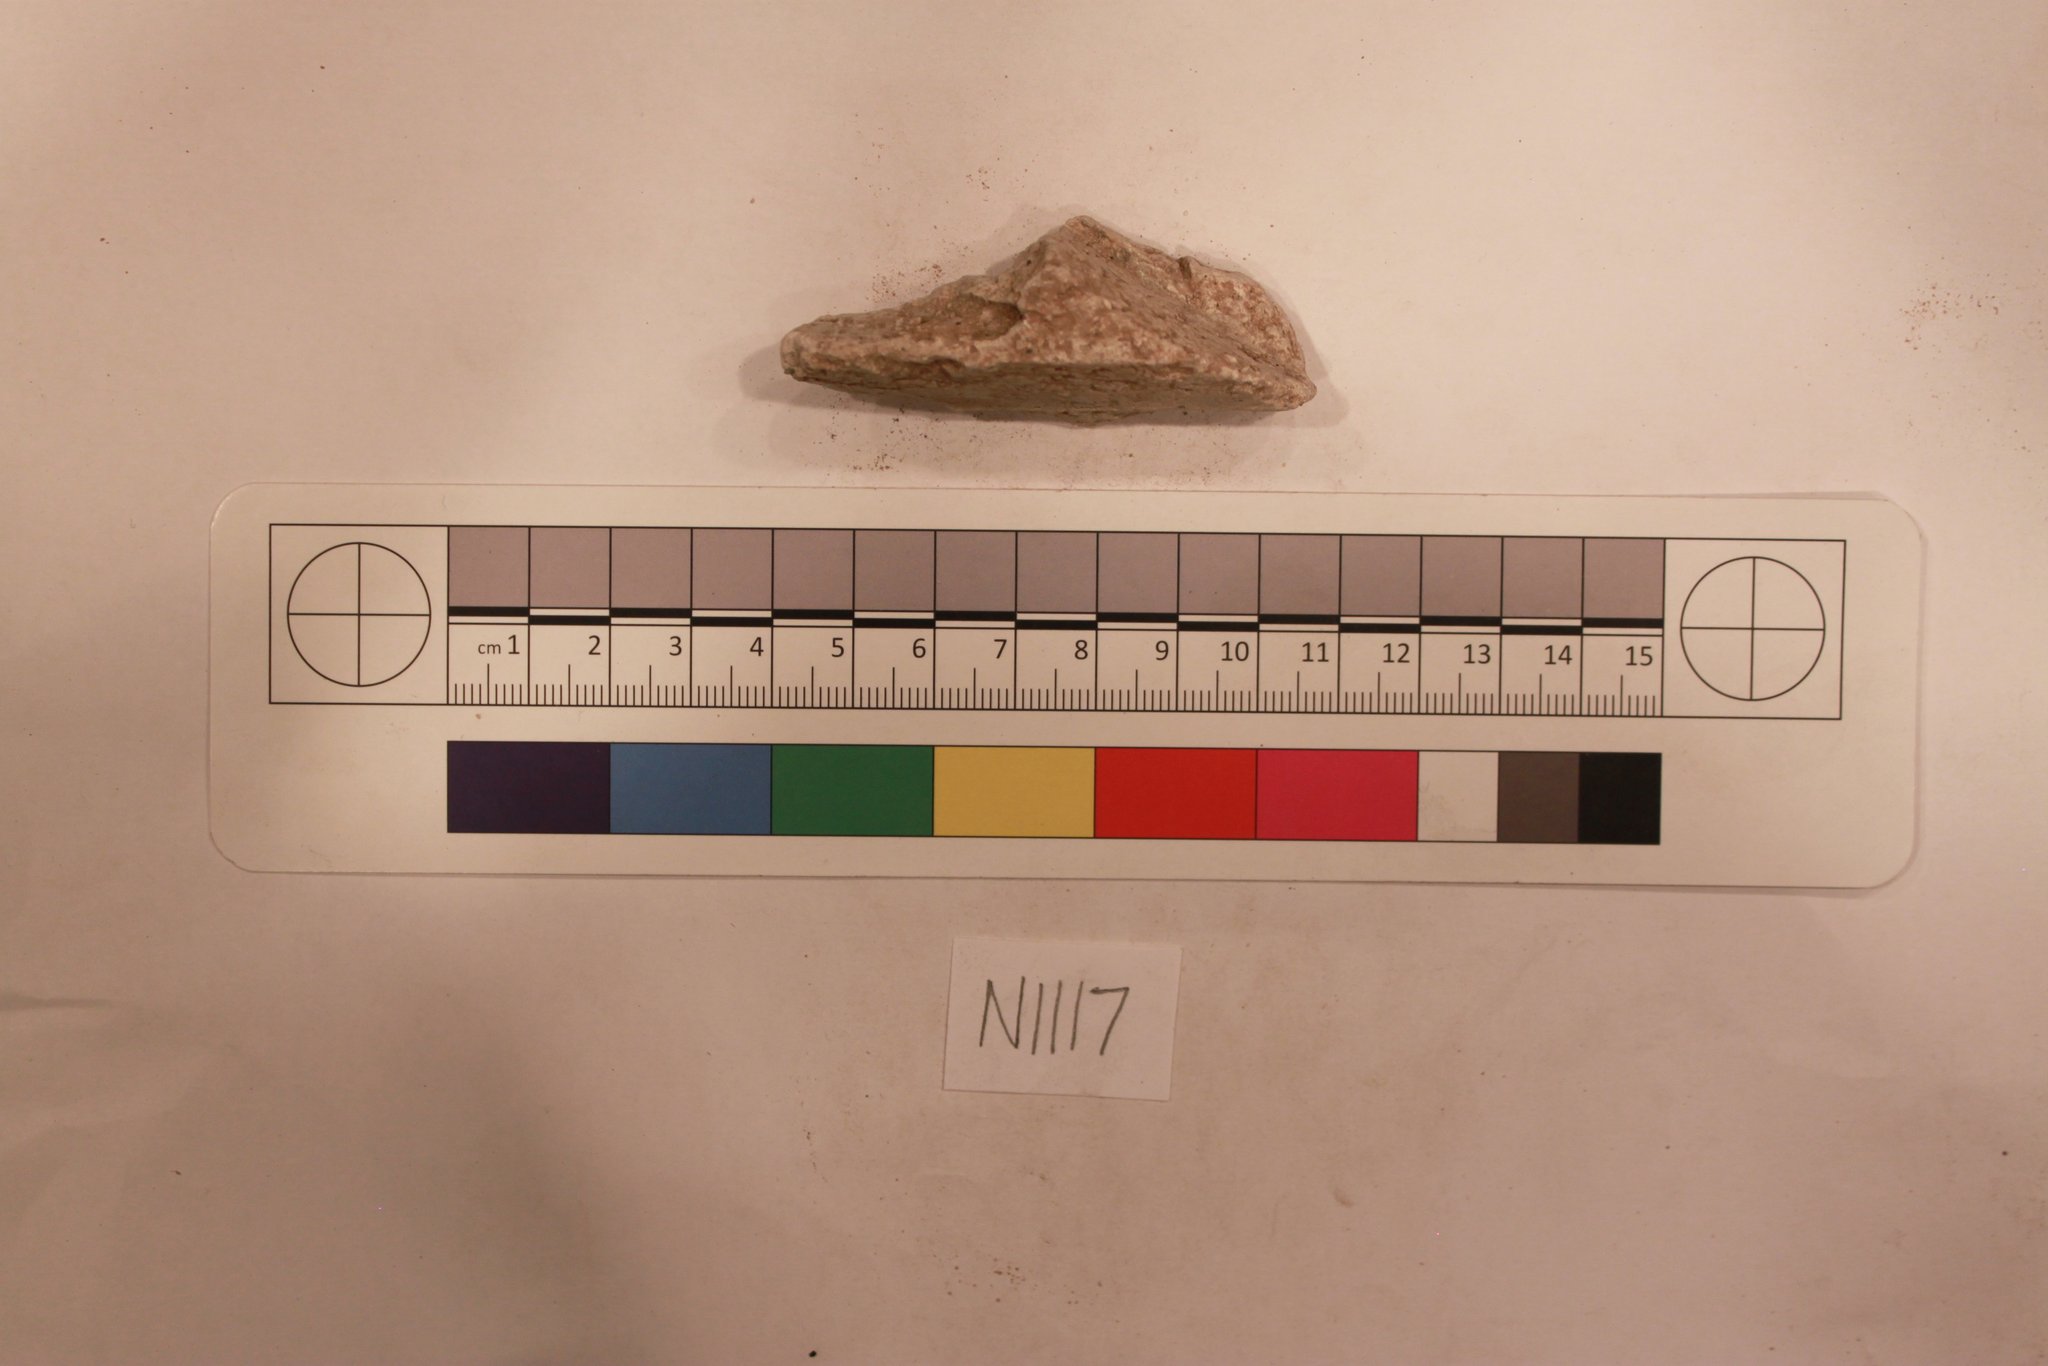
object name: fragment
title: Stucco Fragment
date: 701-1200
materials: plaster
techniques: carving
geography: iran